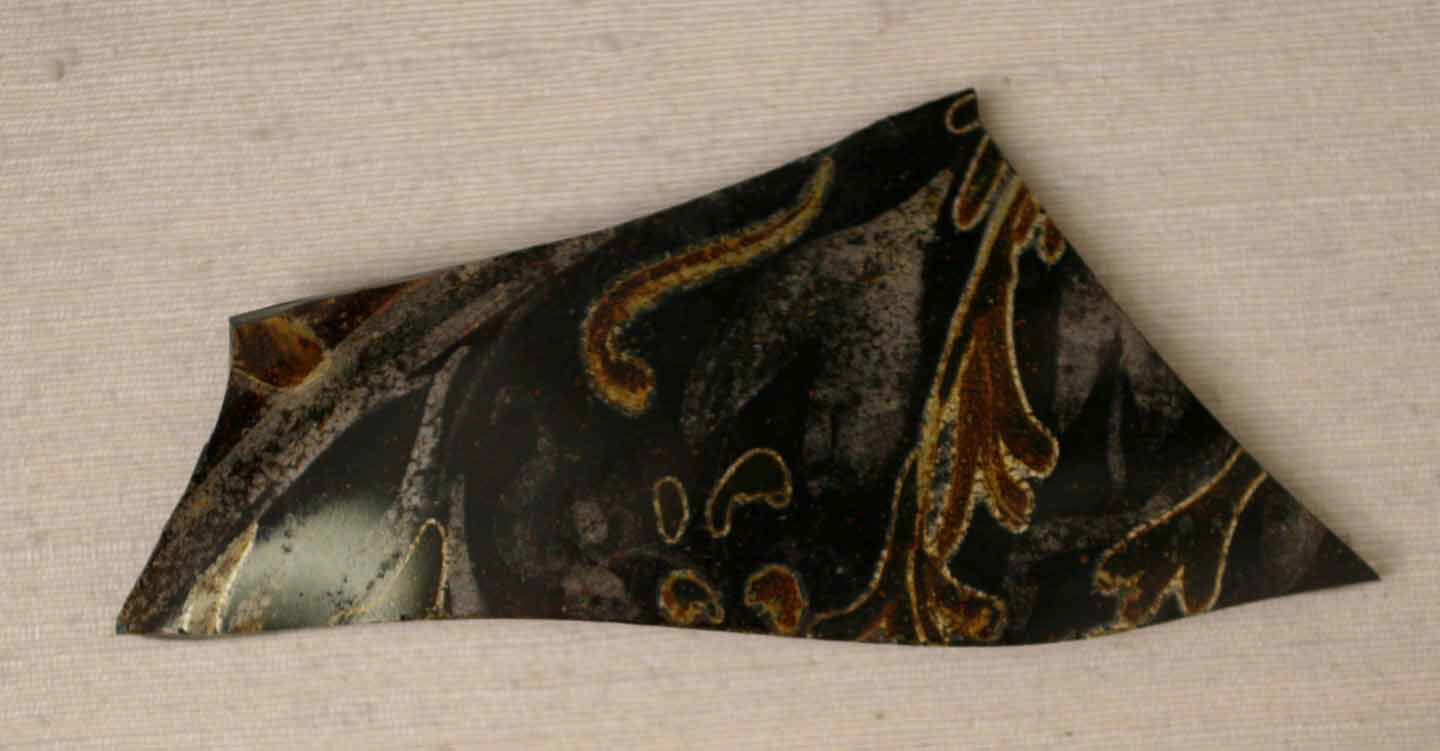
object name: fragment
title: Glass Fragment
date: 901-1100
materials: glass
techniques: luster painting, stain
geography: egypt